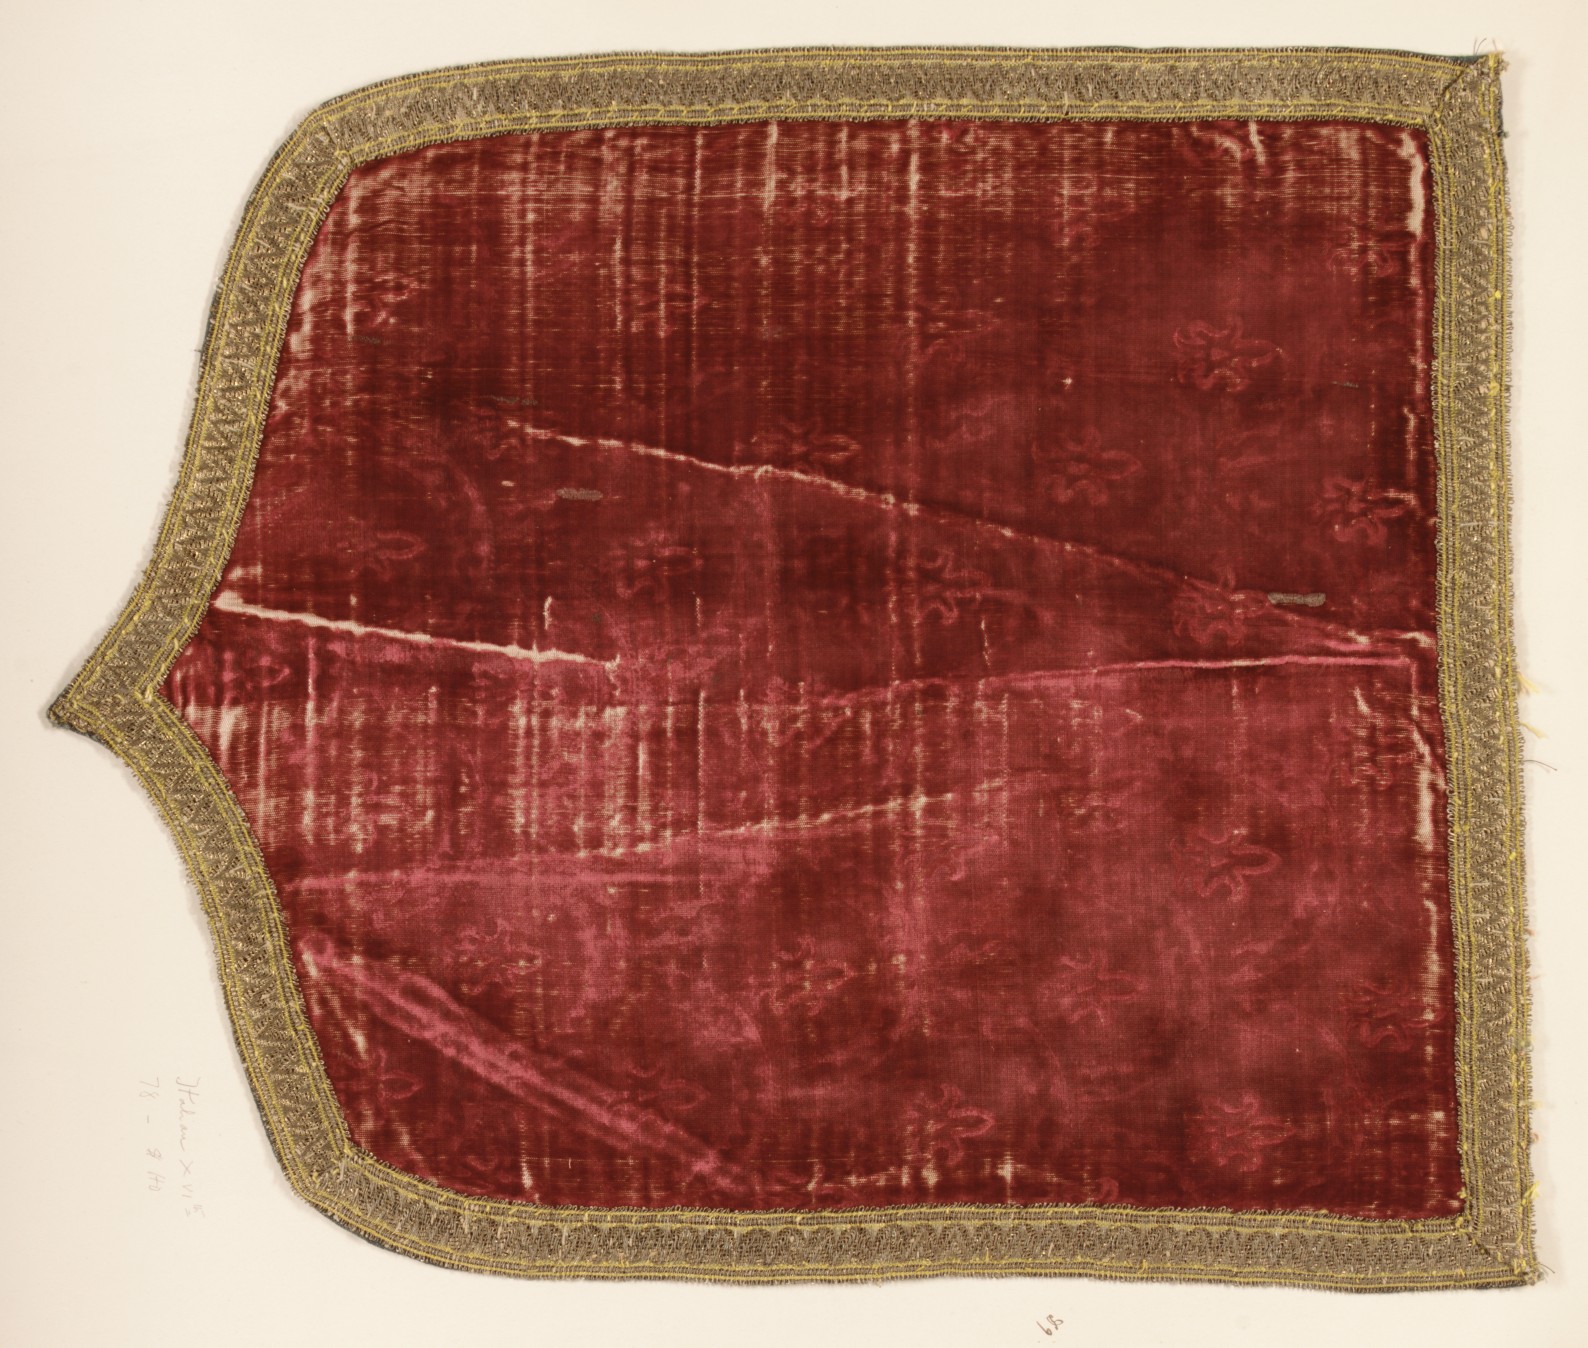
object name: fragment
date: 1567-1600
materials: metal thread, silk